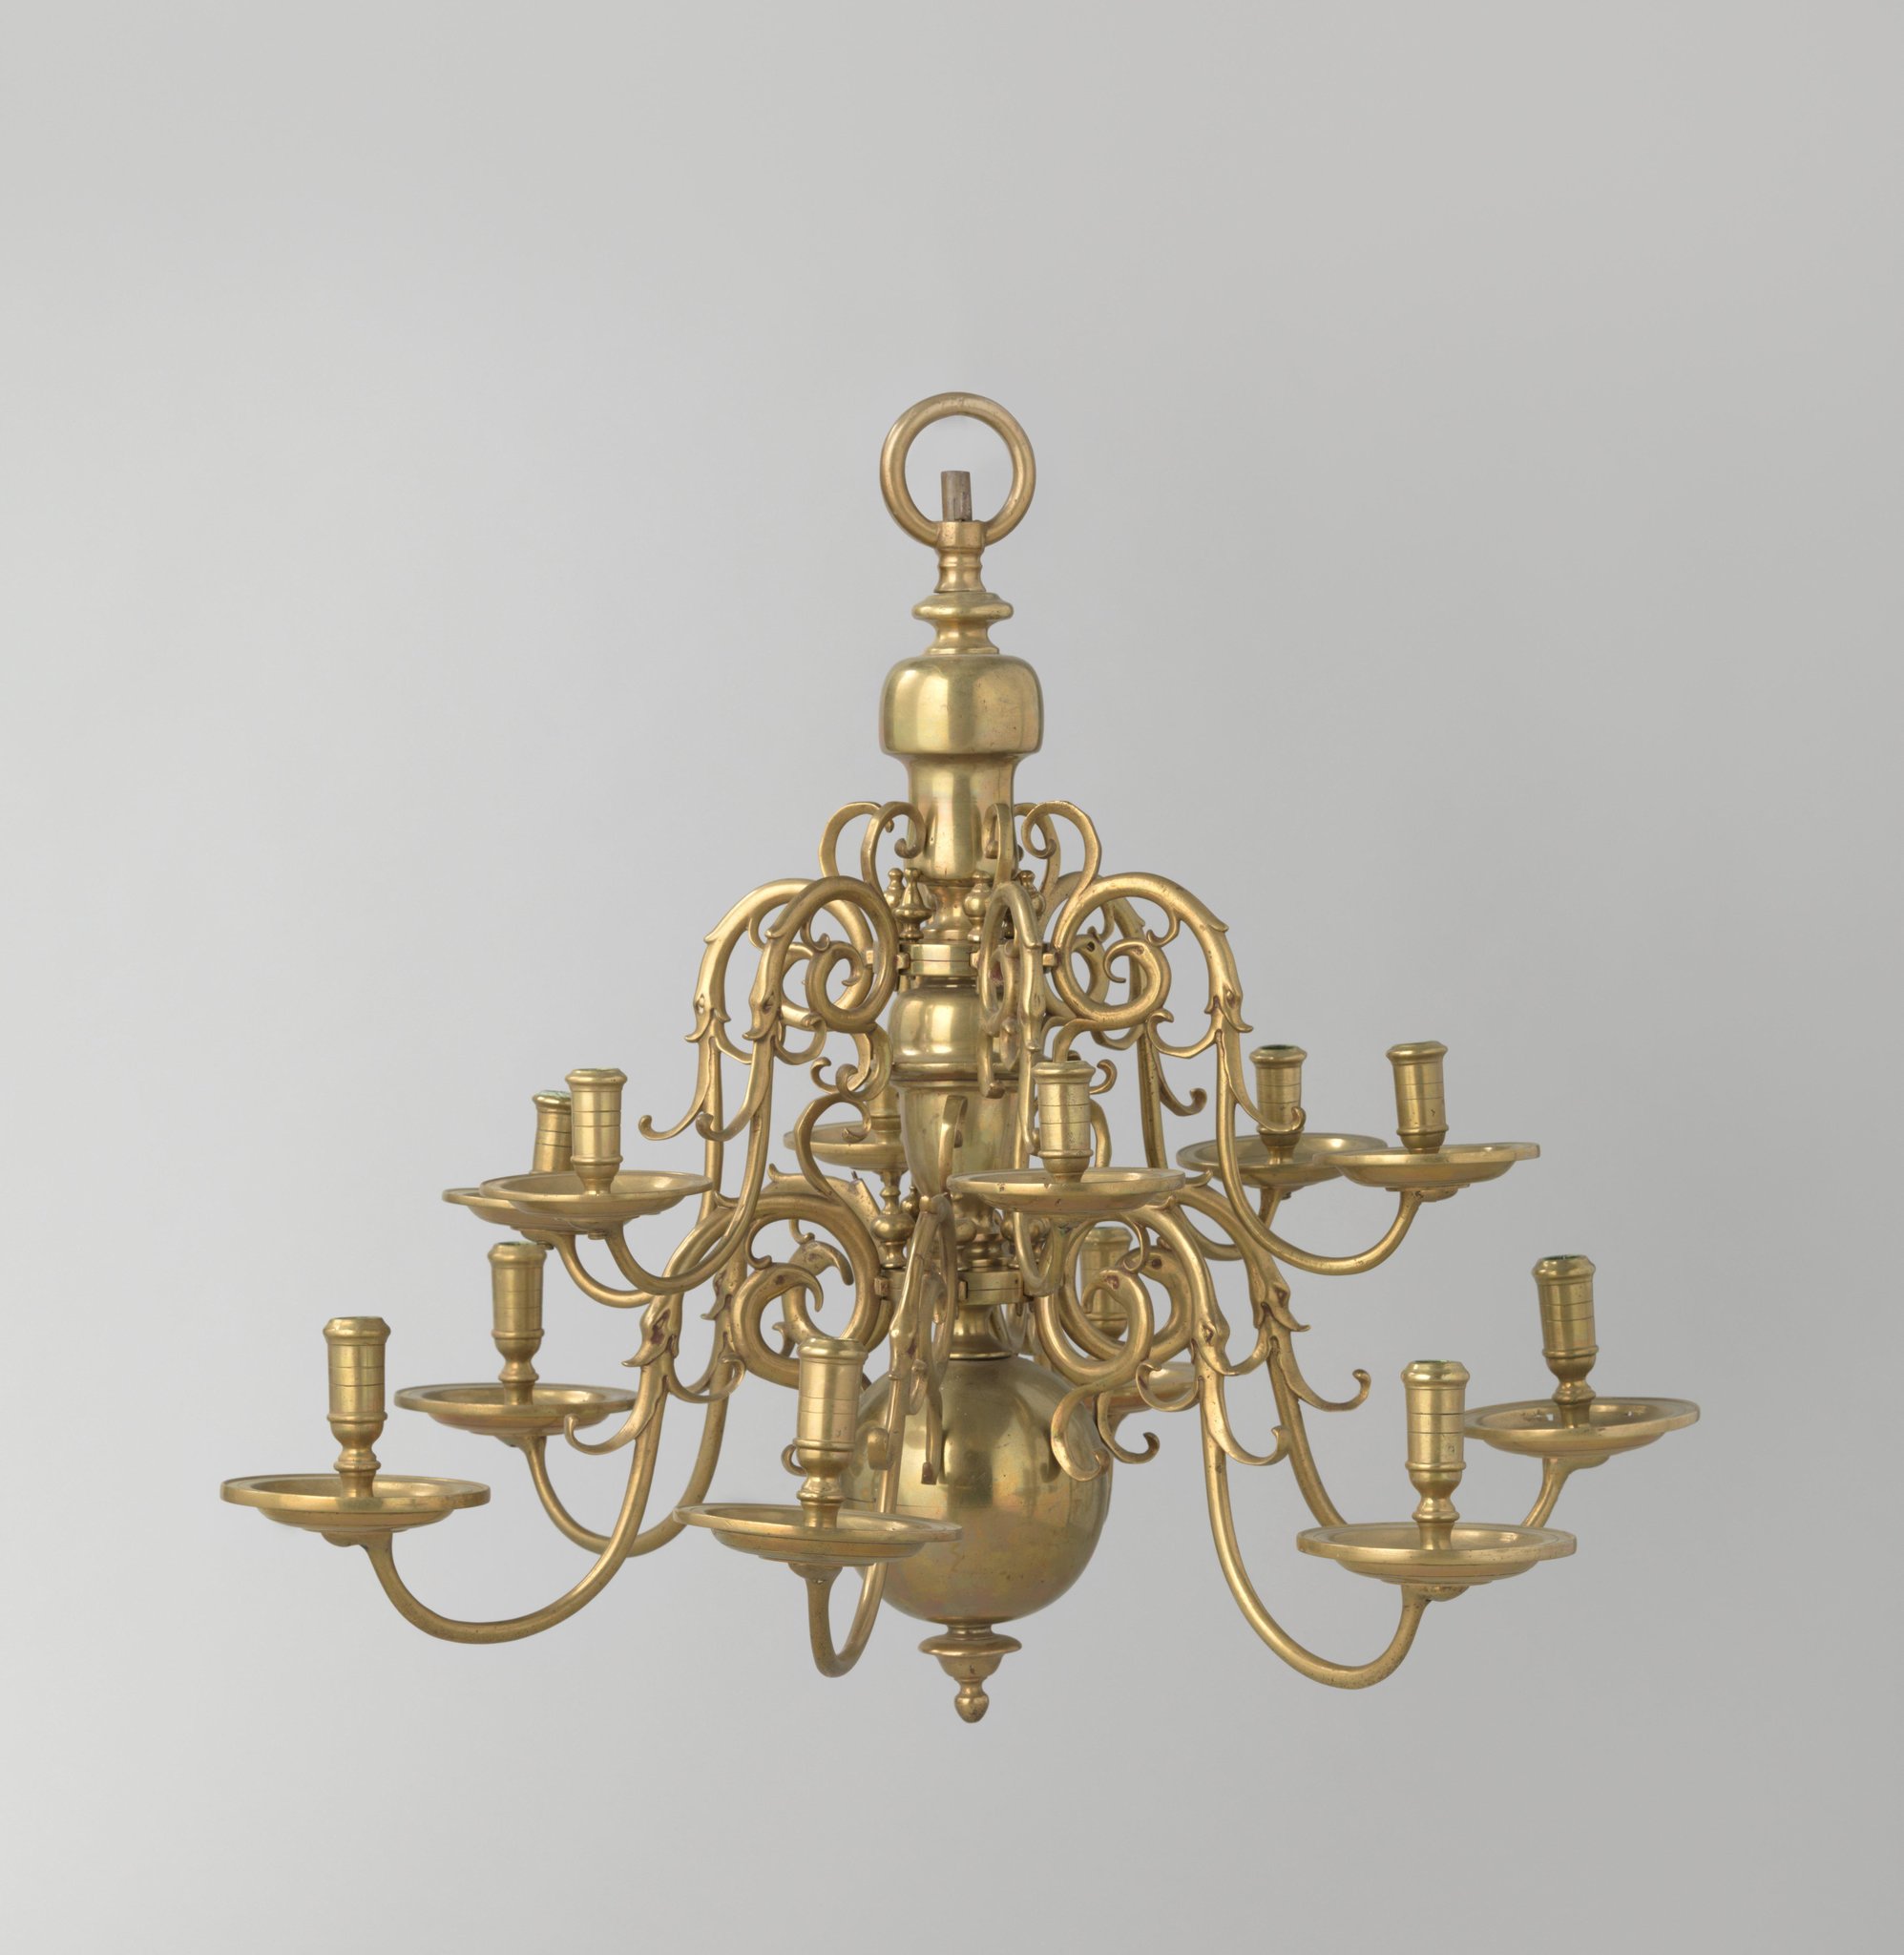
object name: chandelier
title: Arm met kaarsenhouder van kaarsenkroon van twee hoogten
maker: Anonymous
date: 1800-1875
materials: brass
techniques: casting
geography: netherlands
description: Kaarsenarm behorende bij een messing kaarsenkroon van twee hoogten. De S-vormige arm heeft een krul bij de aanzet, halverwege een dolfijnenkop en gaat naar buiten toe over in het platte verdikking met een schroefgat. Daarin is de kaarsenhouder met de vetvanger vastgezet. De vetvanger is aan de onderzijde geribd geprofileerd rond de opening en heeft een naar onder en naar boven toe iets uitstekend randje en is versierd met gegroefde forse ringen. De cylindrische kaarsenhouder heeft een geprofileerde en een weinig uitstekende rand, twee gegroefde ringen, een rib en een geprofileerd holrond onderstuk, dat overgaat in een uitsteeksel met een schroefdraad met een centergat. Dit is de zesde arm van de bovenste standring, ongenummerd.